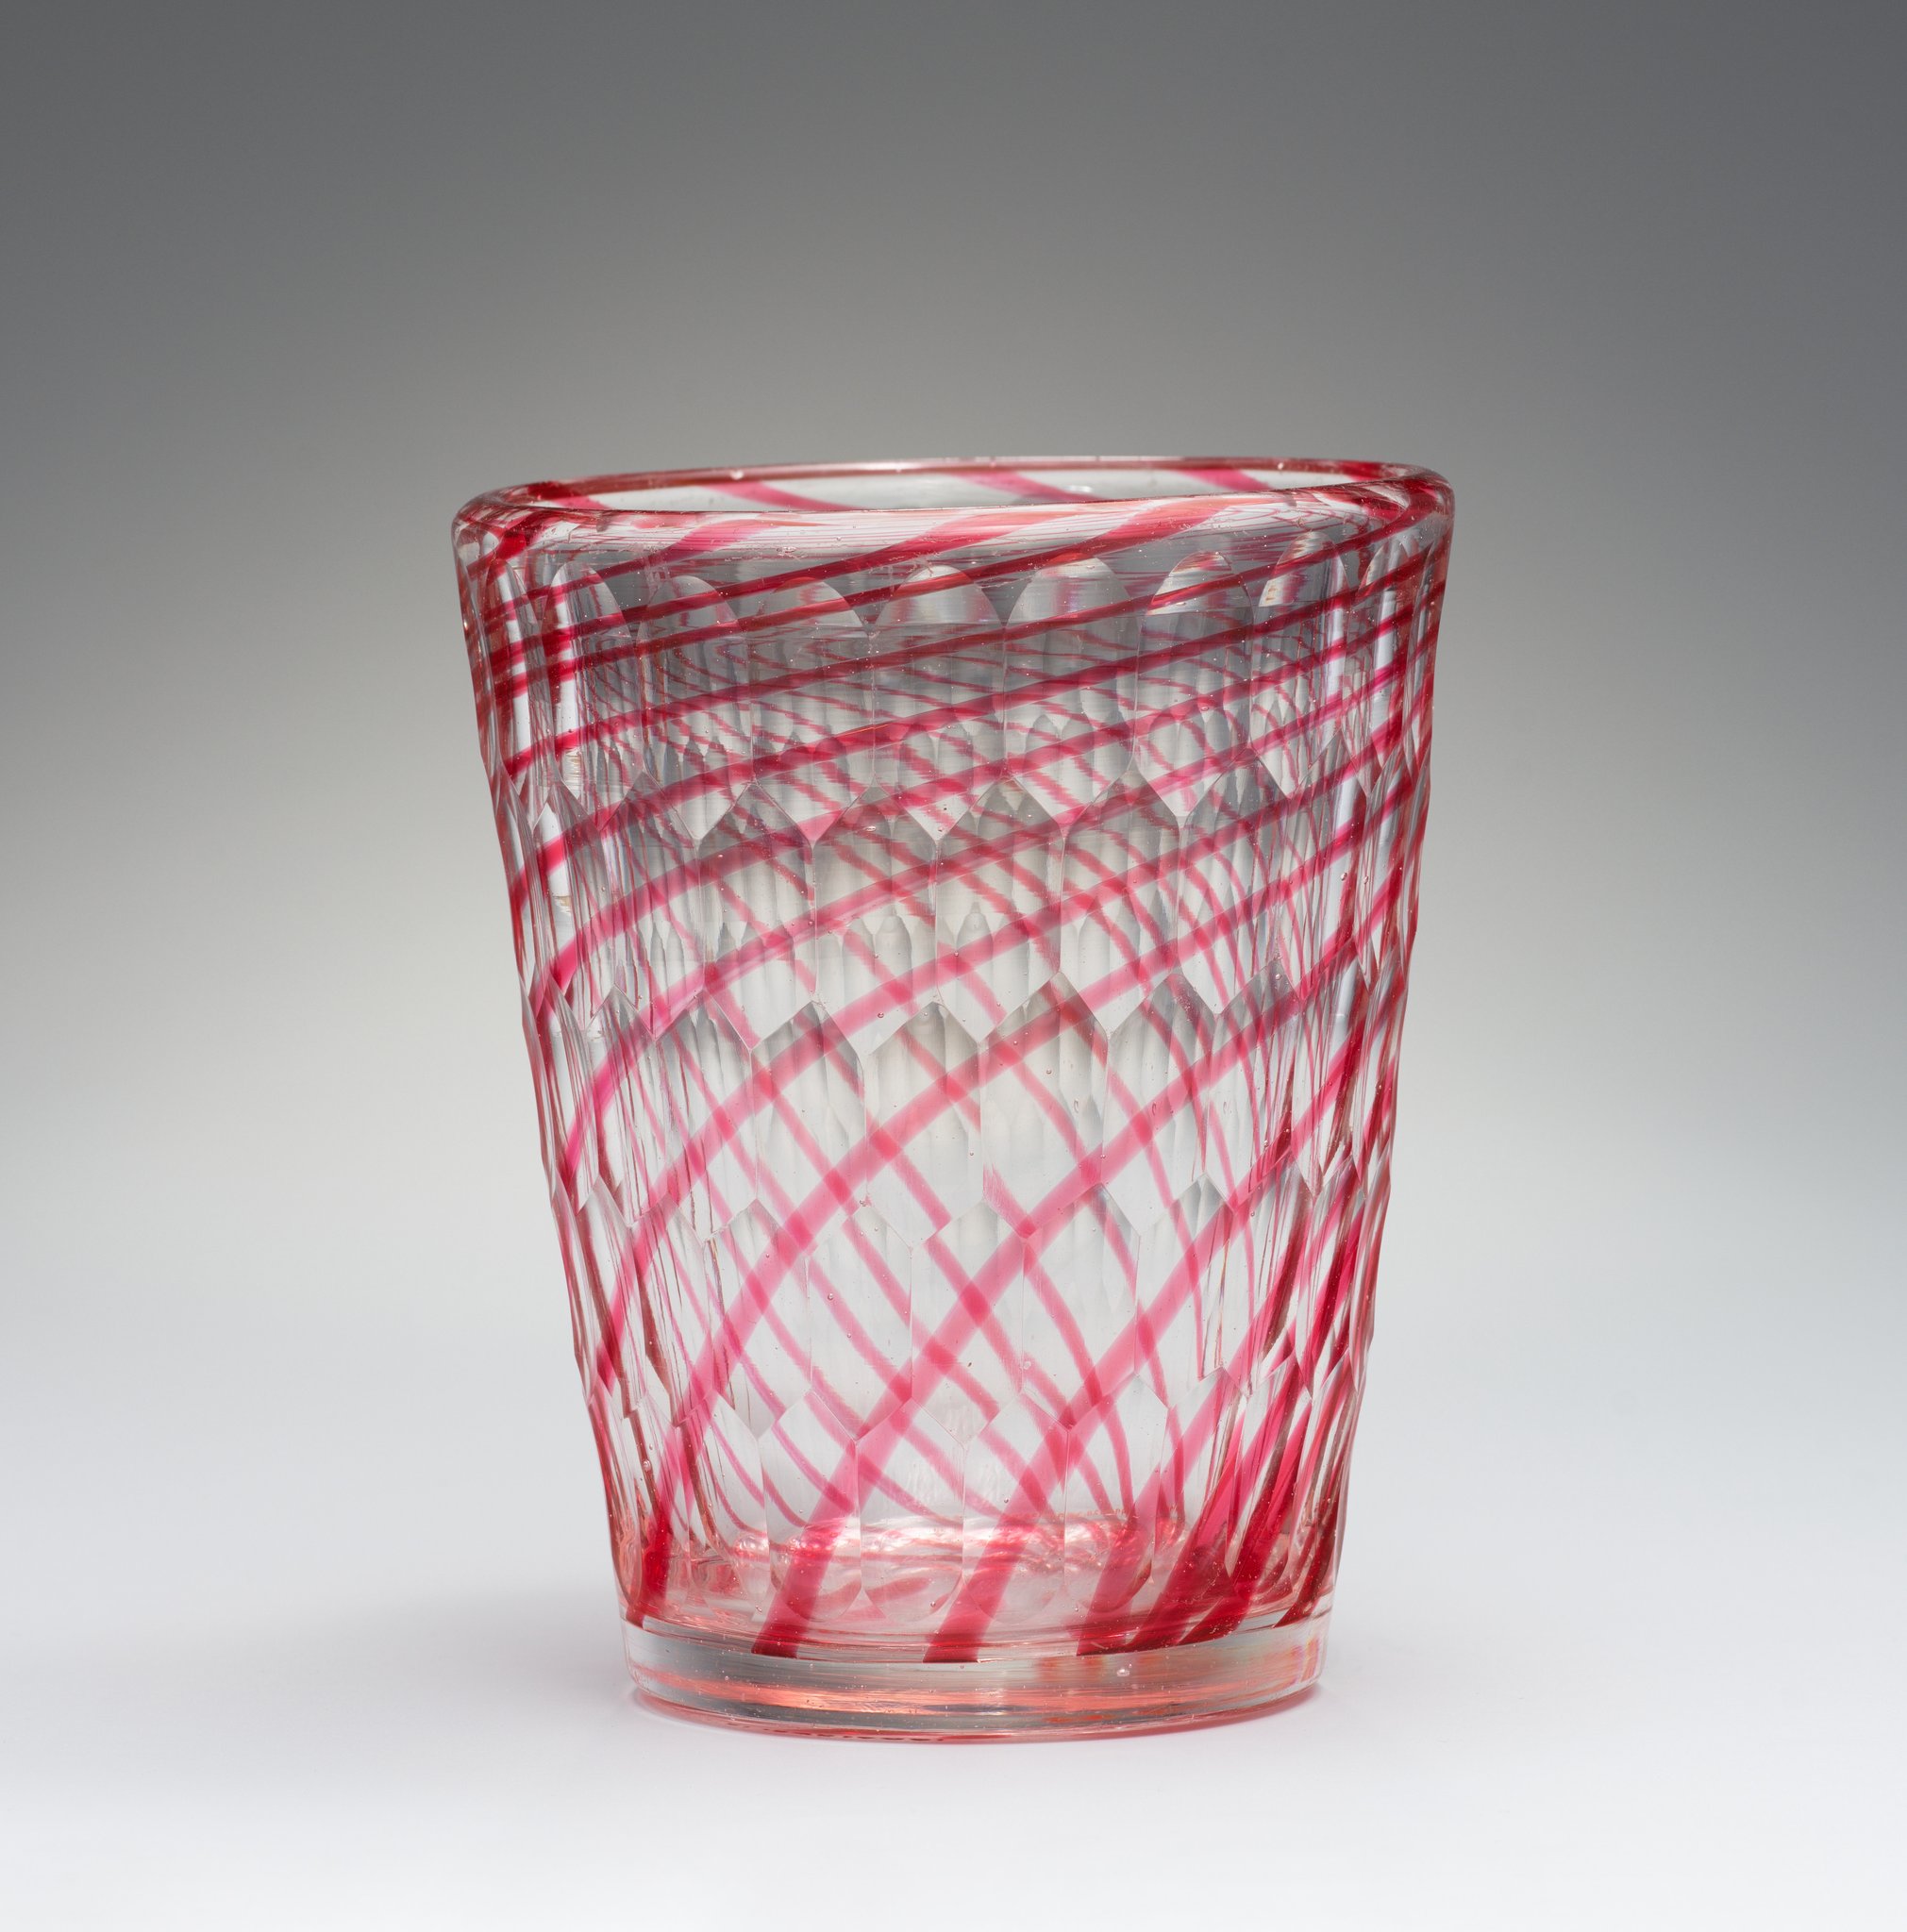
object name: beaker with cover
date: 1720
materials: glass